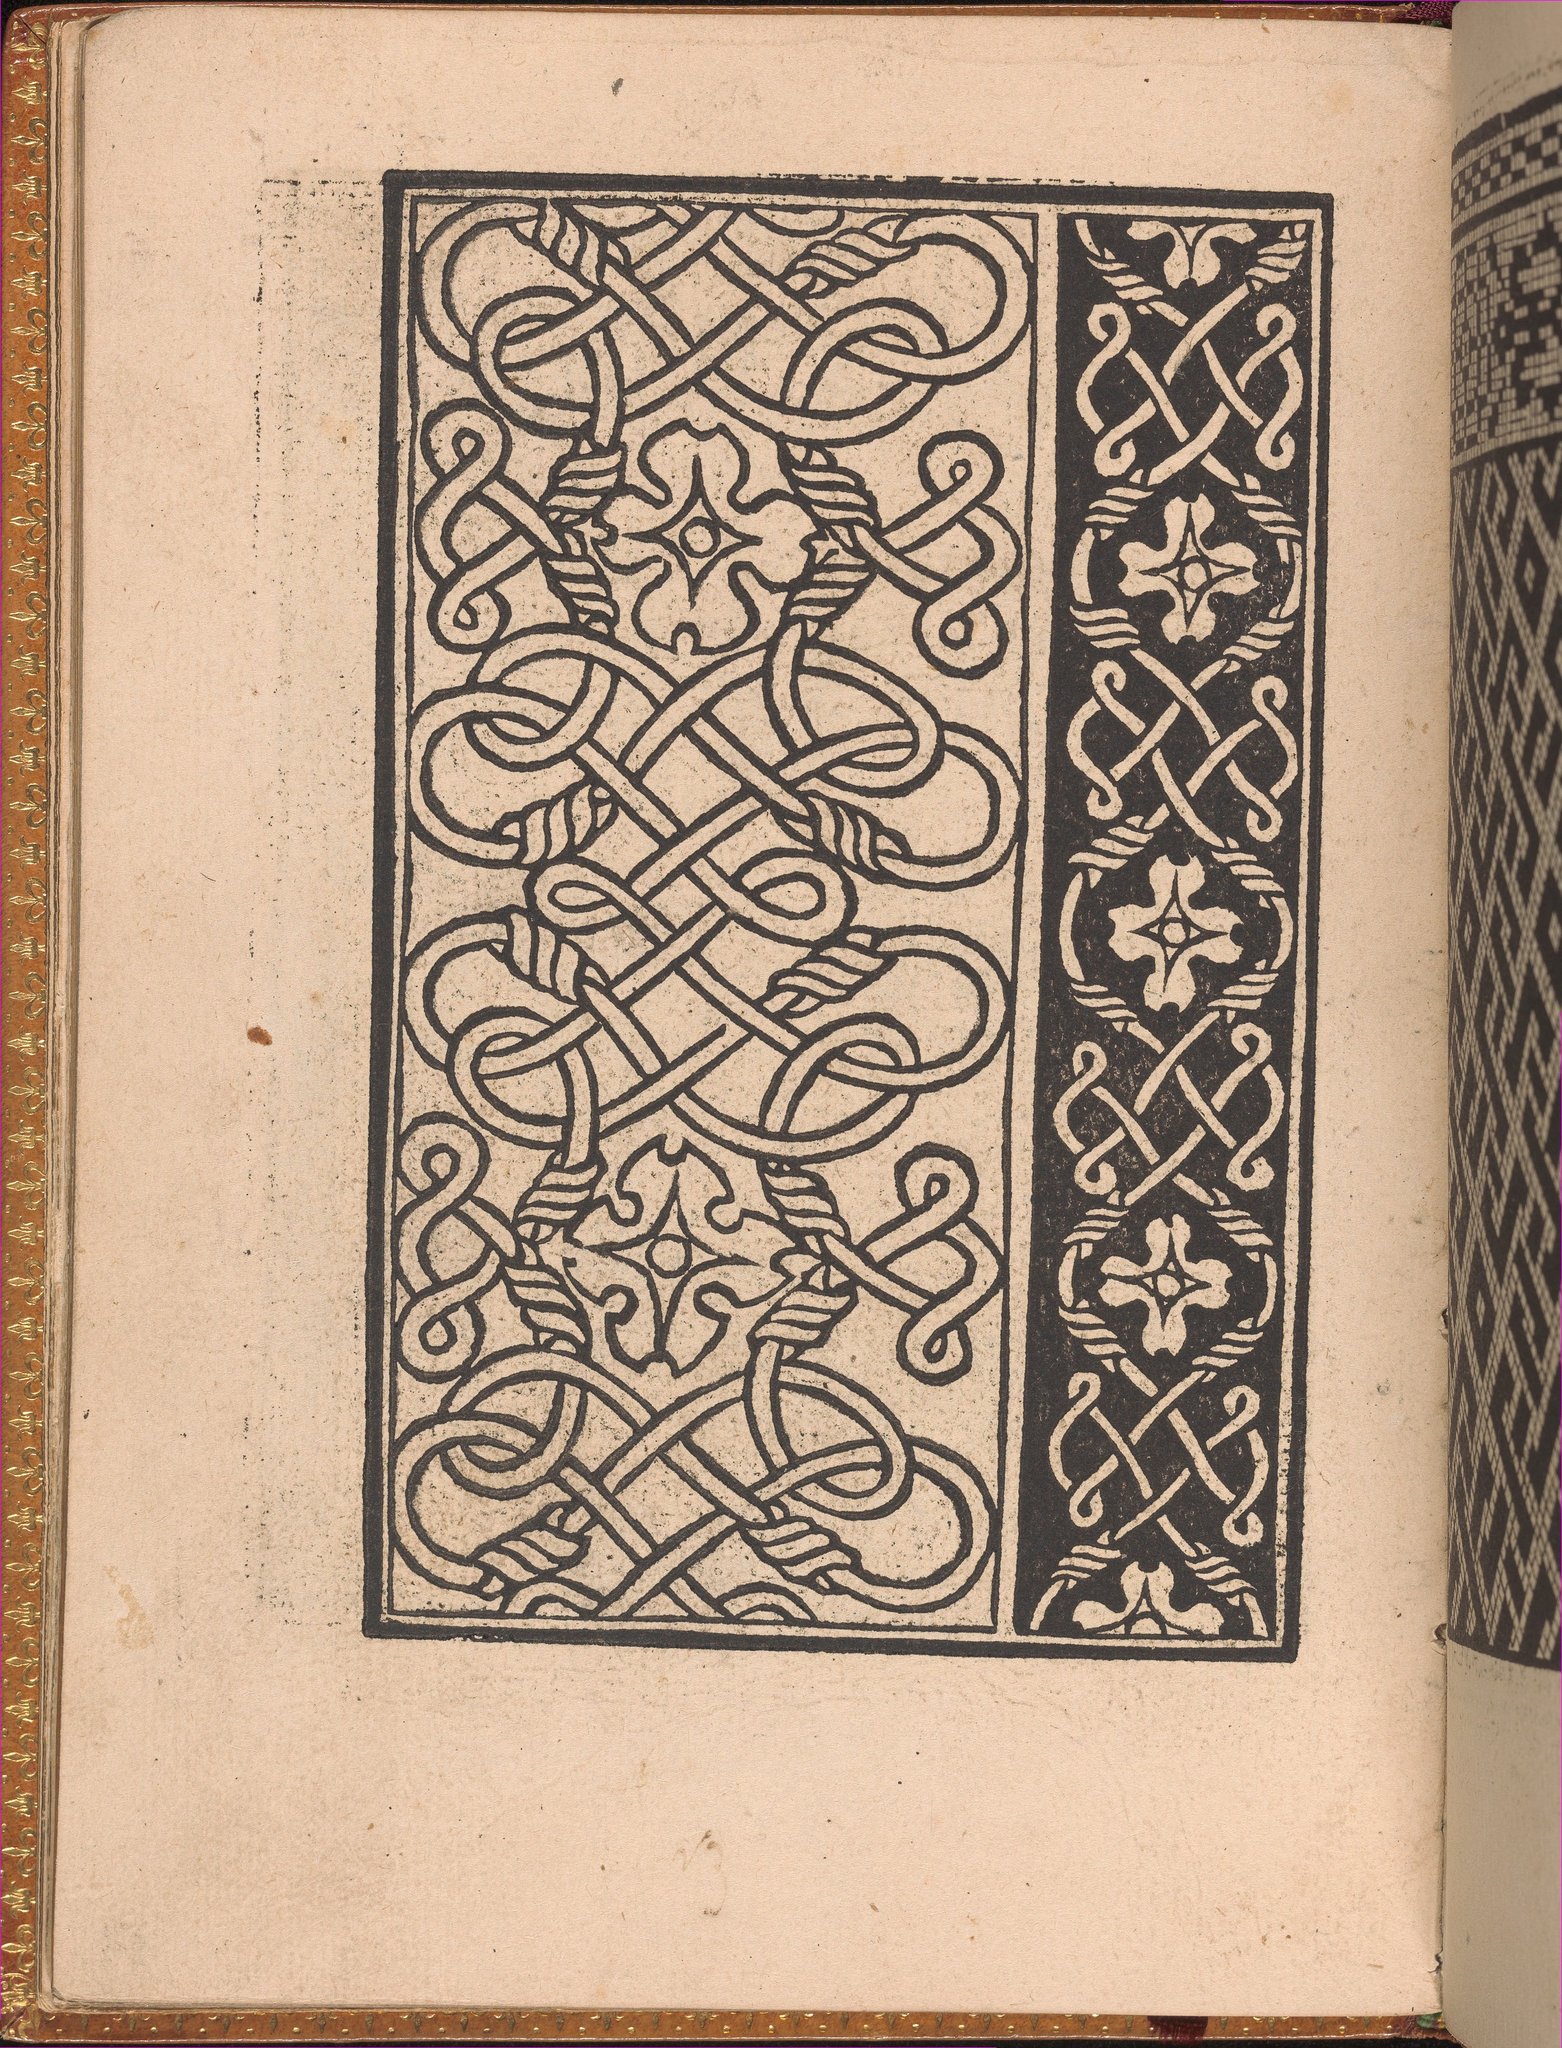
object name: book print ornament architecture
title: Convivio delle Belle Donne, page 17 (verso)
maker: nicolò zoppino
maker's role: publisher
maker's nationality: italian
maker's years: 1478-1544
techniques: woodcut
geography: italy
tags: flowers,vines